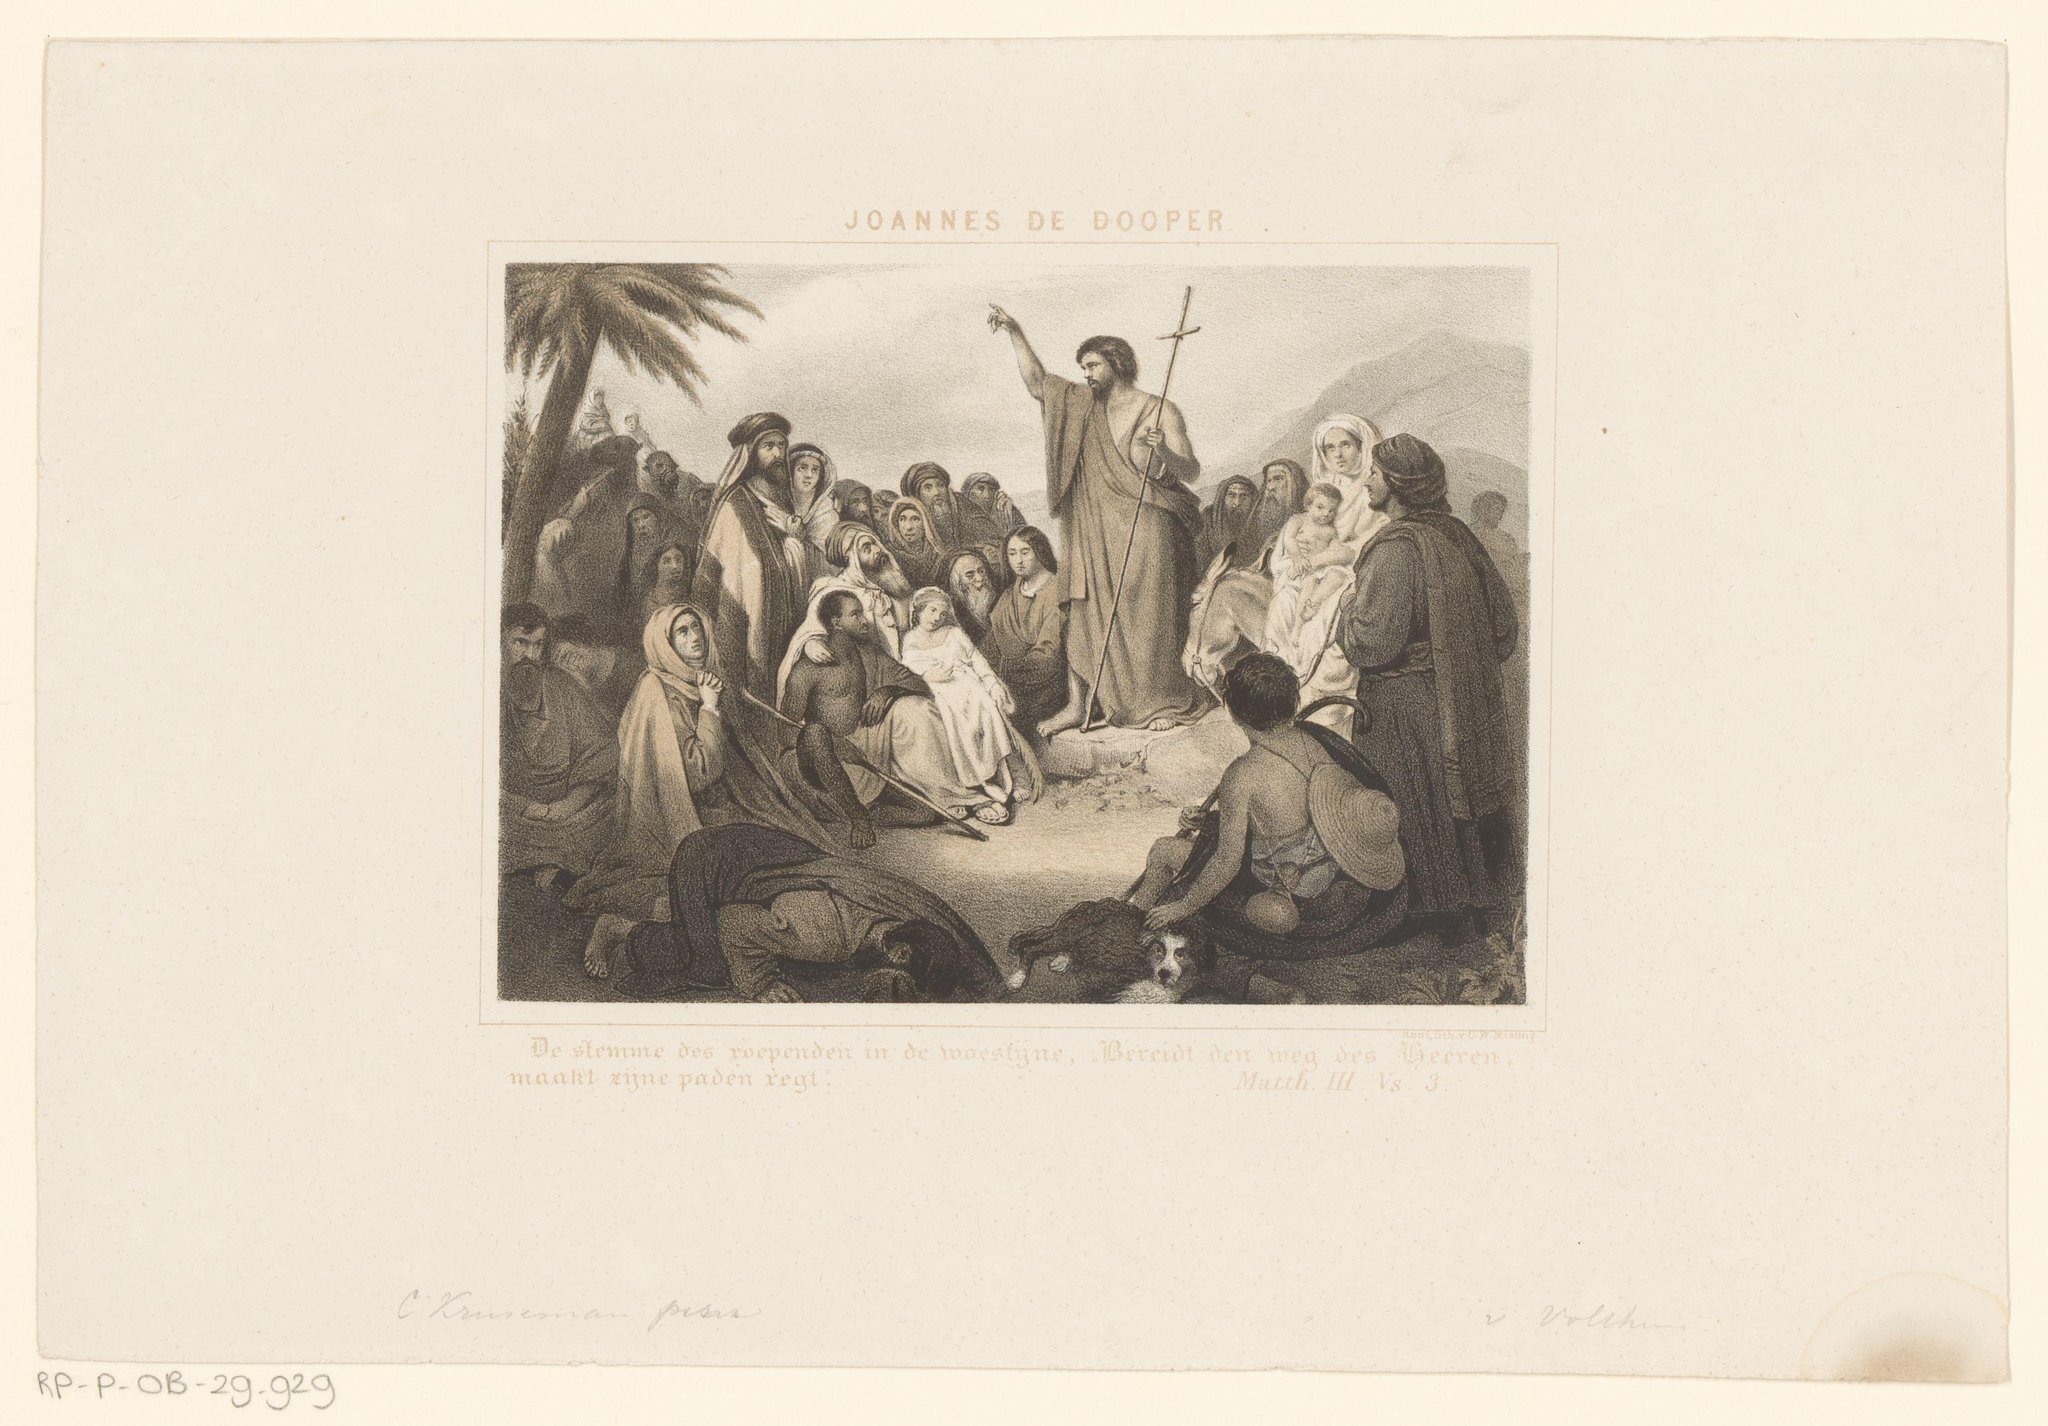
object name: print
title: Johannes de Doper predikend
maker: anthonie van volkom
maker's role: print maker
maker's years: 1821-1860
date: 1847-1865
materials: paper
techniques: tone lithography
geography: the hague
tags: john the baptist preaching (perhaps christ among the bystanders)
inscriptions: collector's mark: Lugt 2228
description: Johannes de Doper predikend in de woestijn. Rondom hem een groep mensen.